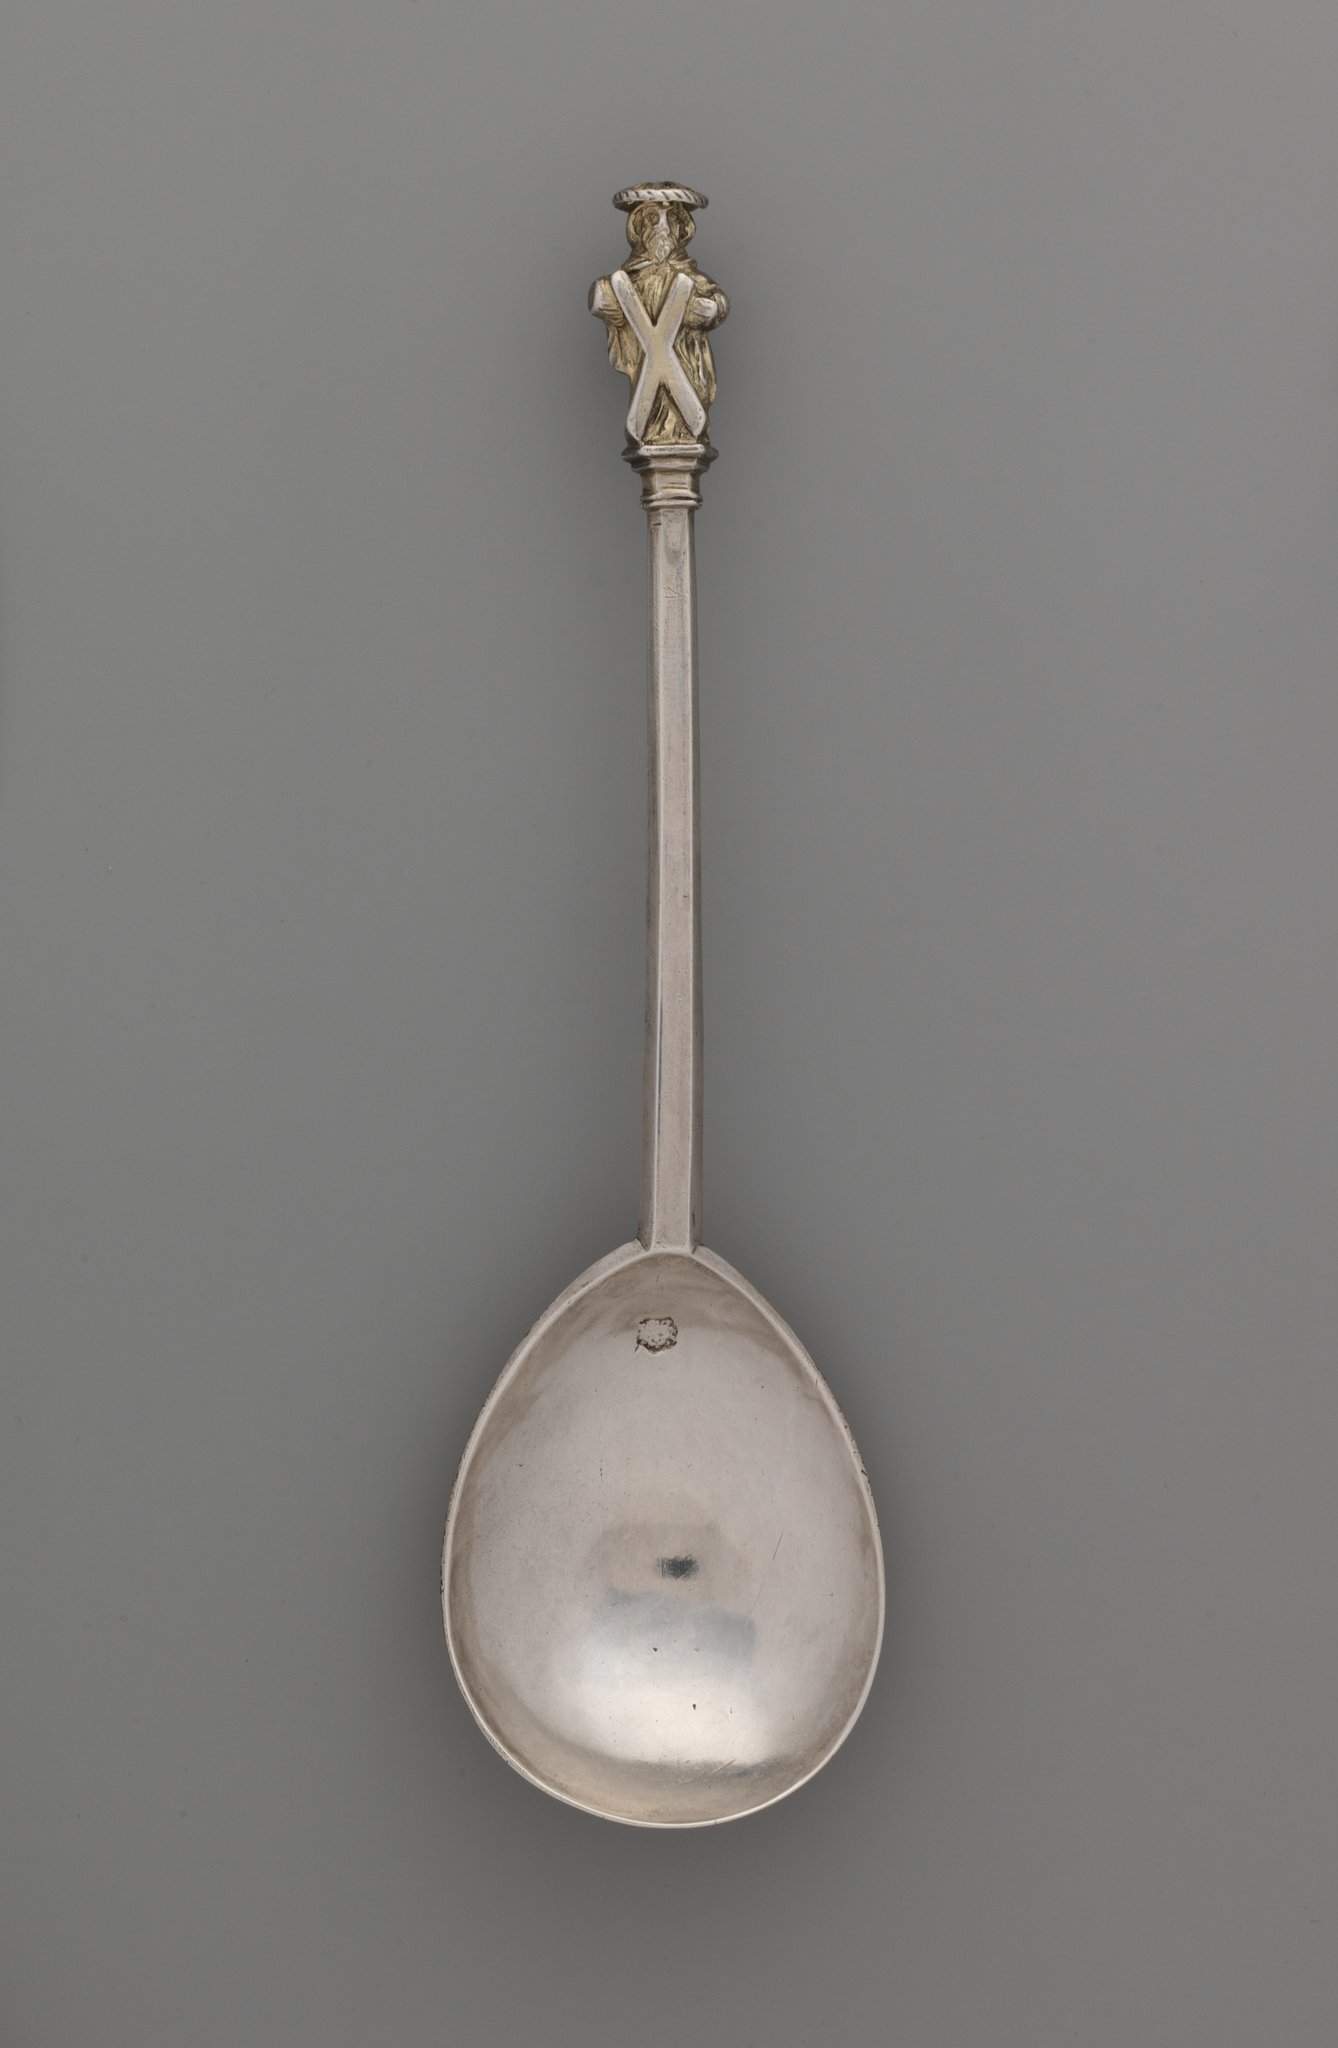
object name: apostle spoon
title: Apostle spoon: St. Andrew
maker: martin hewitt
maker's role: maker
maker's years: 1613-1623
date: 1613-1614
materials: silver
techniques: gilding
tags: apostles